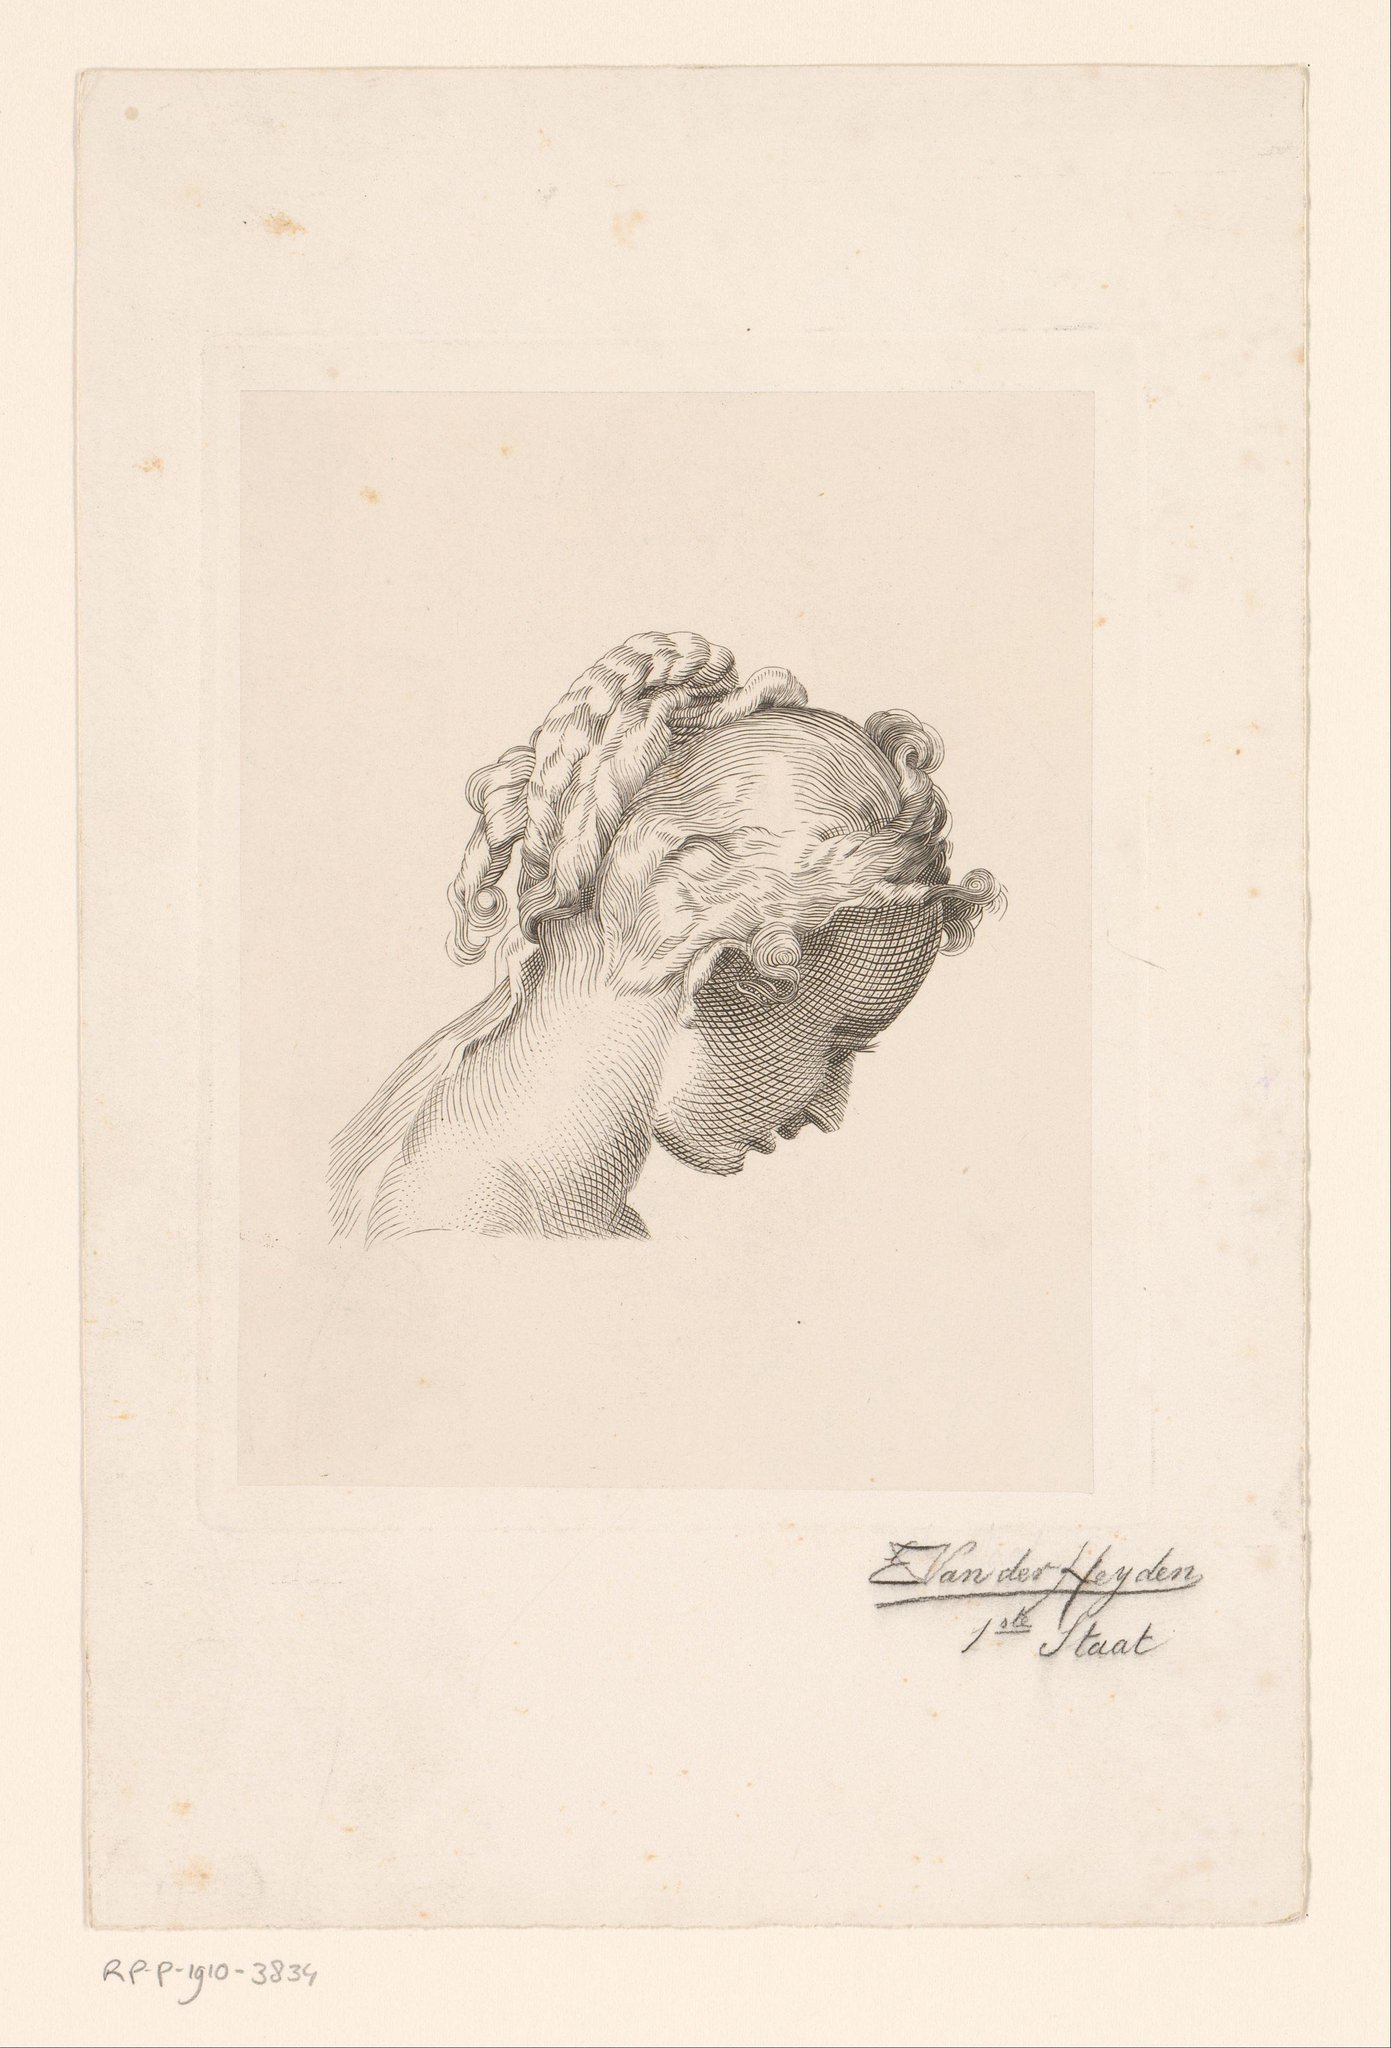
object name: print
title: Buste van een neerkijkende vrouw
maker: e. van der heyden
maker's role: print maker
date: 1850-1899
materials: paper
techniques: engraving, etching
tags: adolescent, young woman, maiden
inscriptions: collector's mark: Lugt 2228, inscription: ‘E van der Heyden; 1ste Staat’